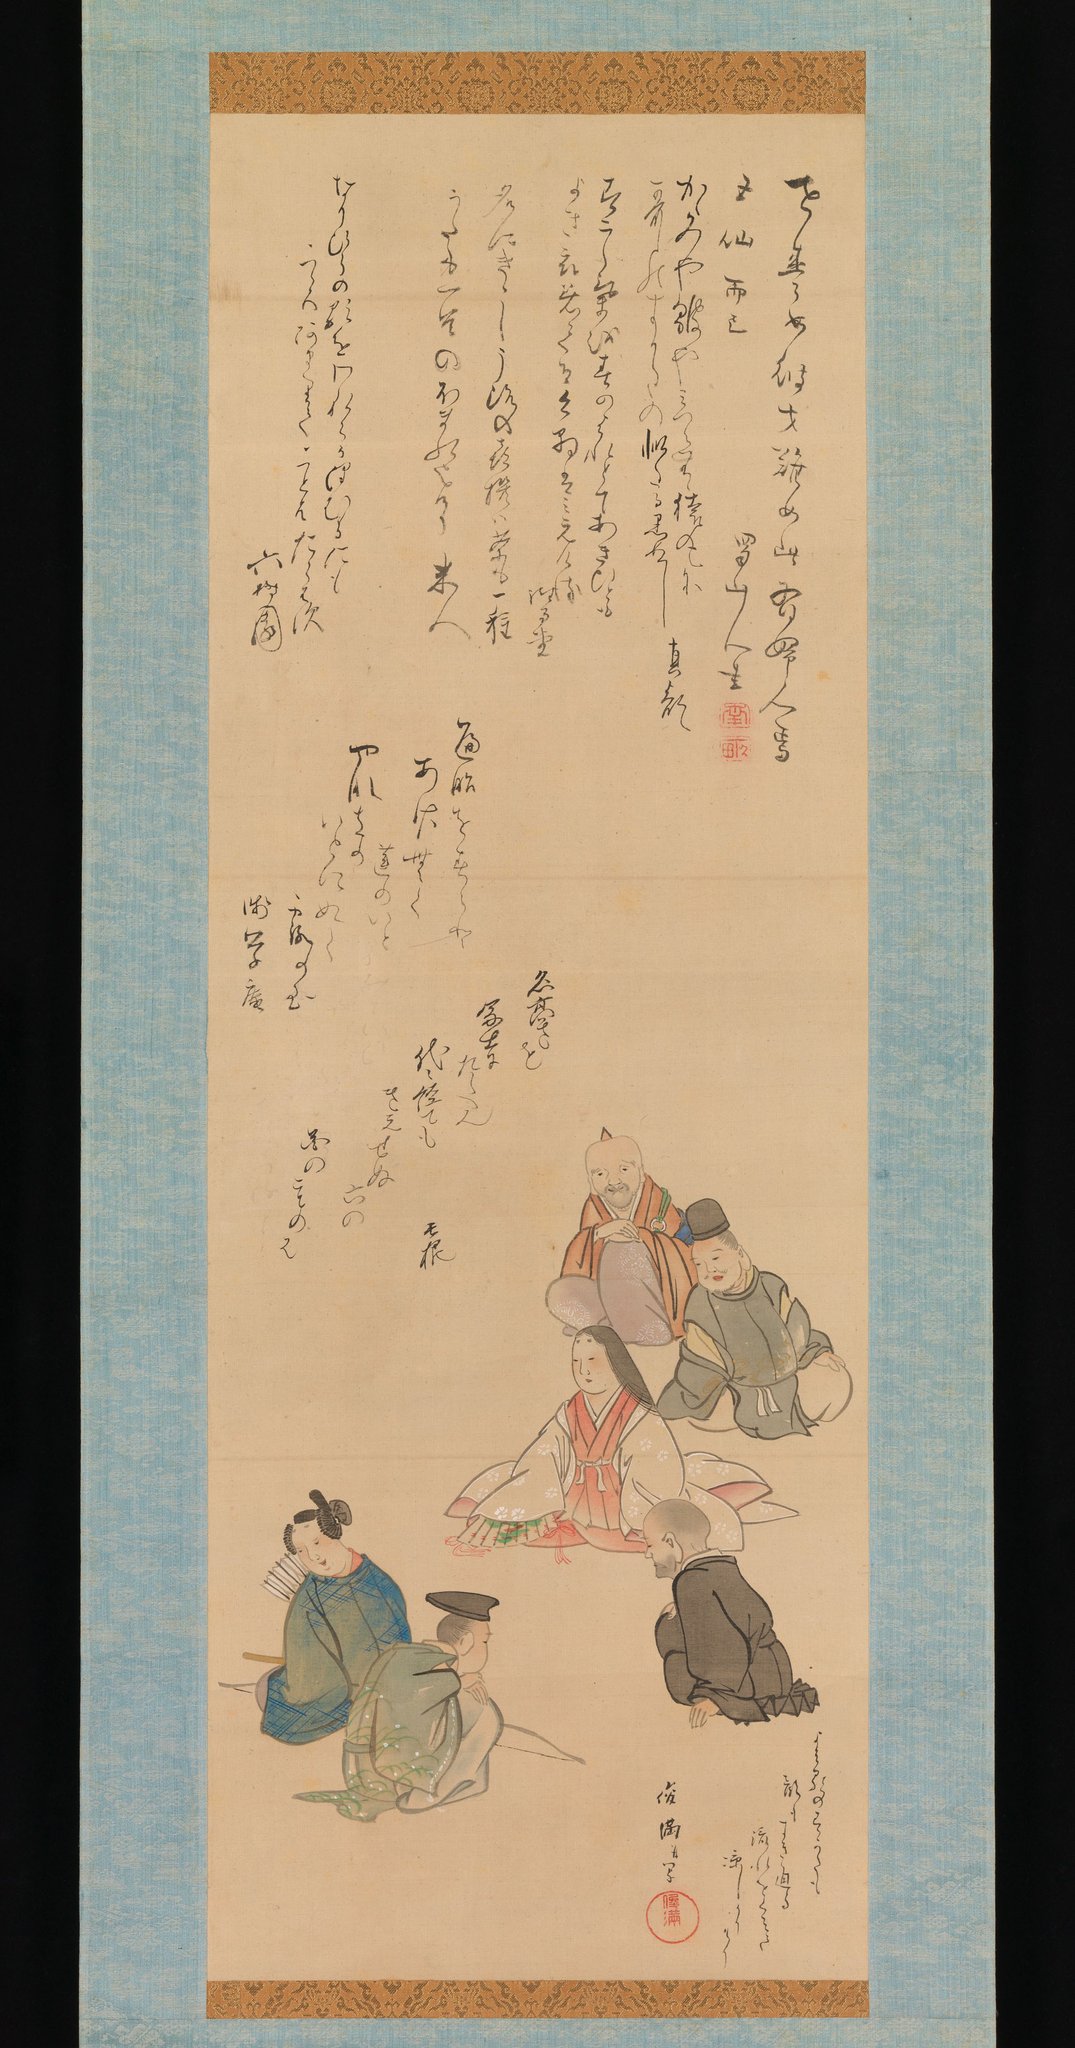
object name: hanging scroll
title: The Six Poetic Immortals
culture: japanese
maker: kubo shunman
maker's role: artist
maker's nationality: japanese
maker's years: 1757-1820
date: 1810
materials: ink, silk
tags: men,women,poets